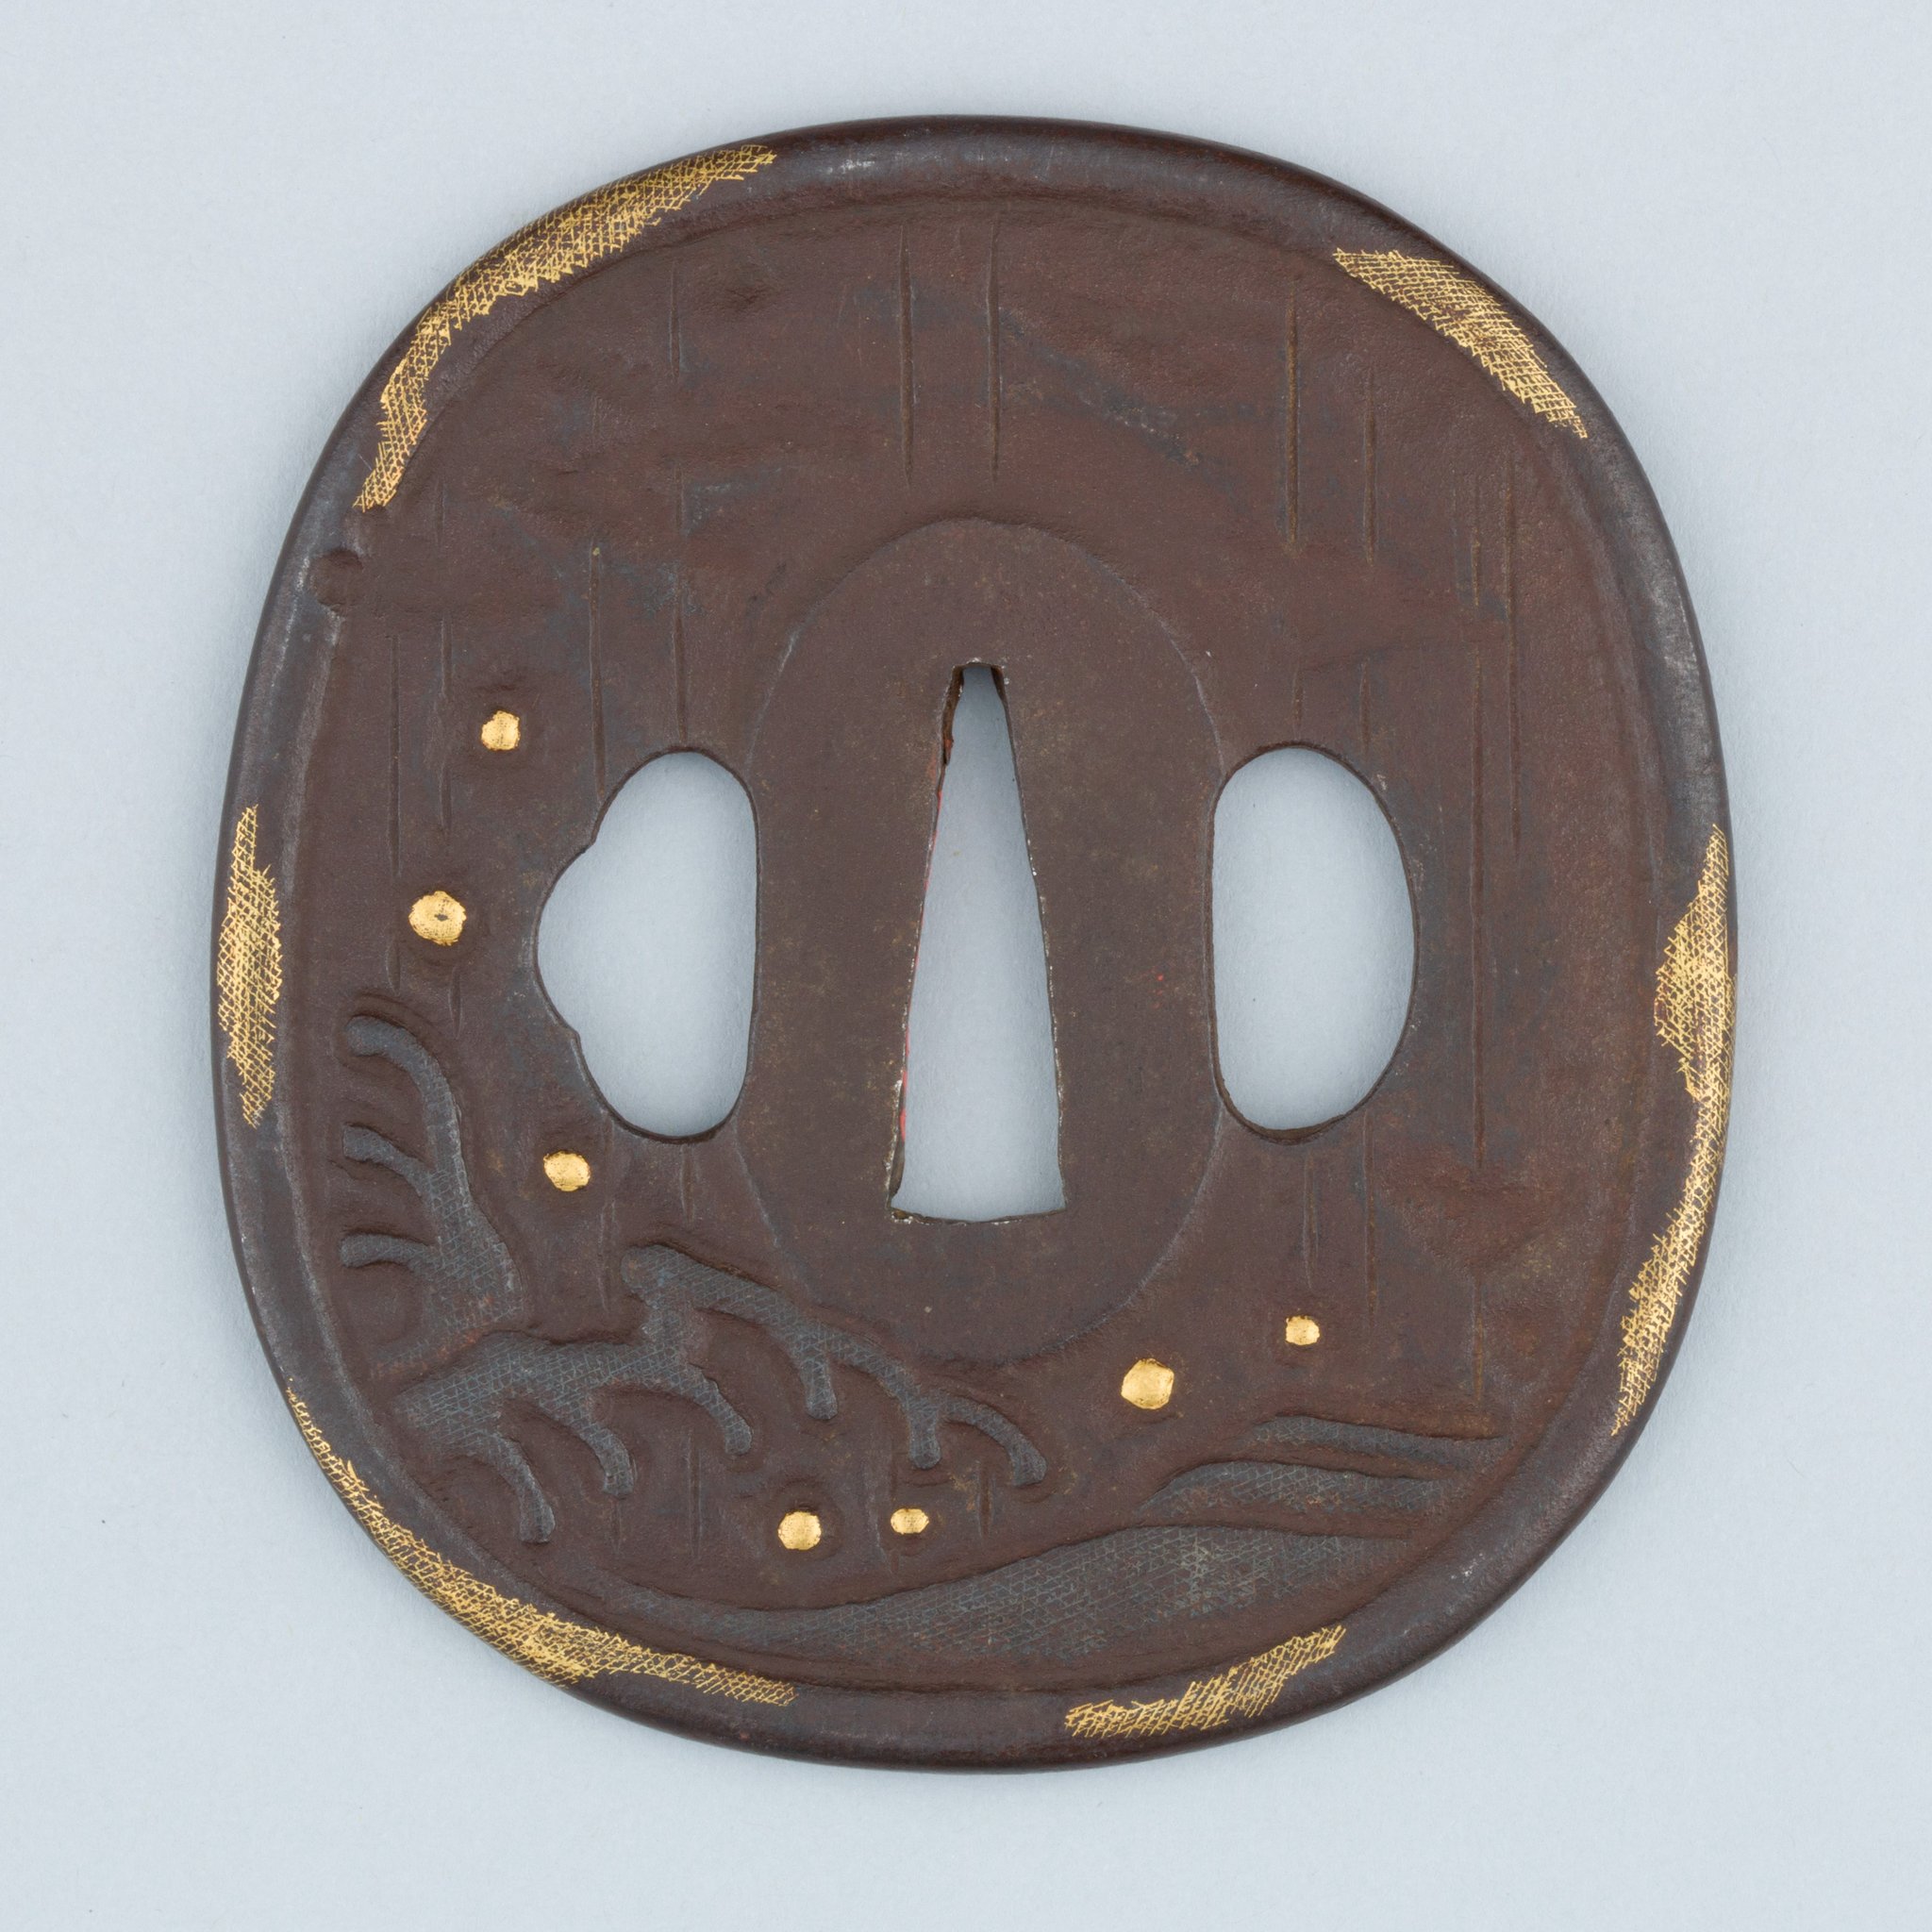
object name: sword guard tsuba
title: Sword Guard (Tsuba)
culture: japanese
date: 1615-1868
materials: copper, gold, iron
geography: japan